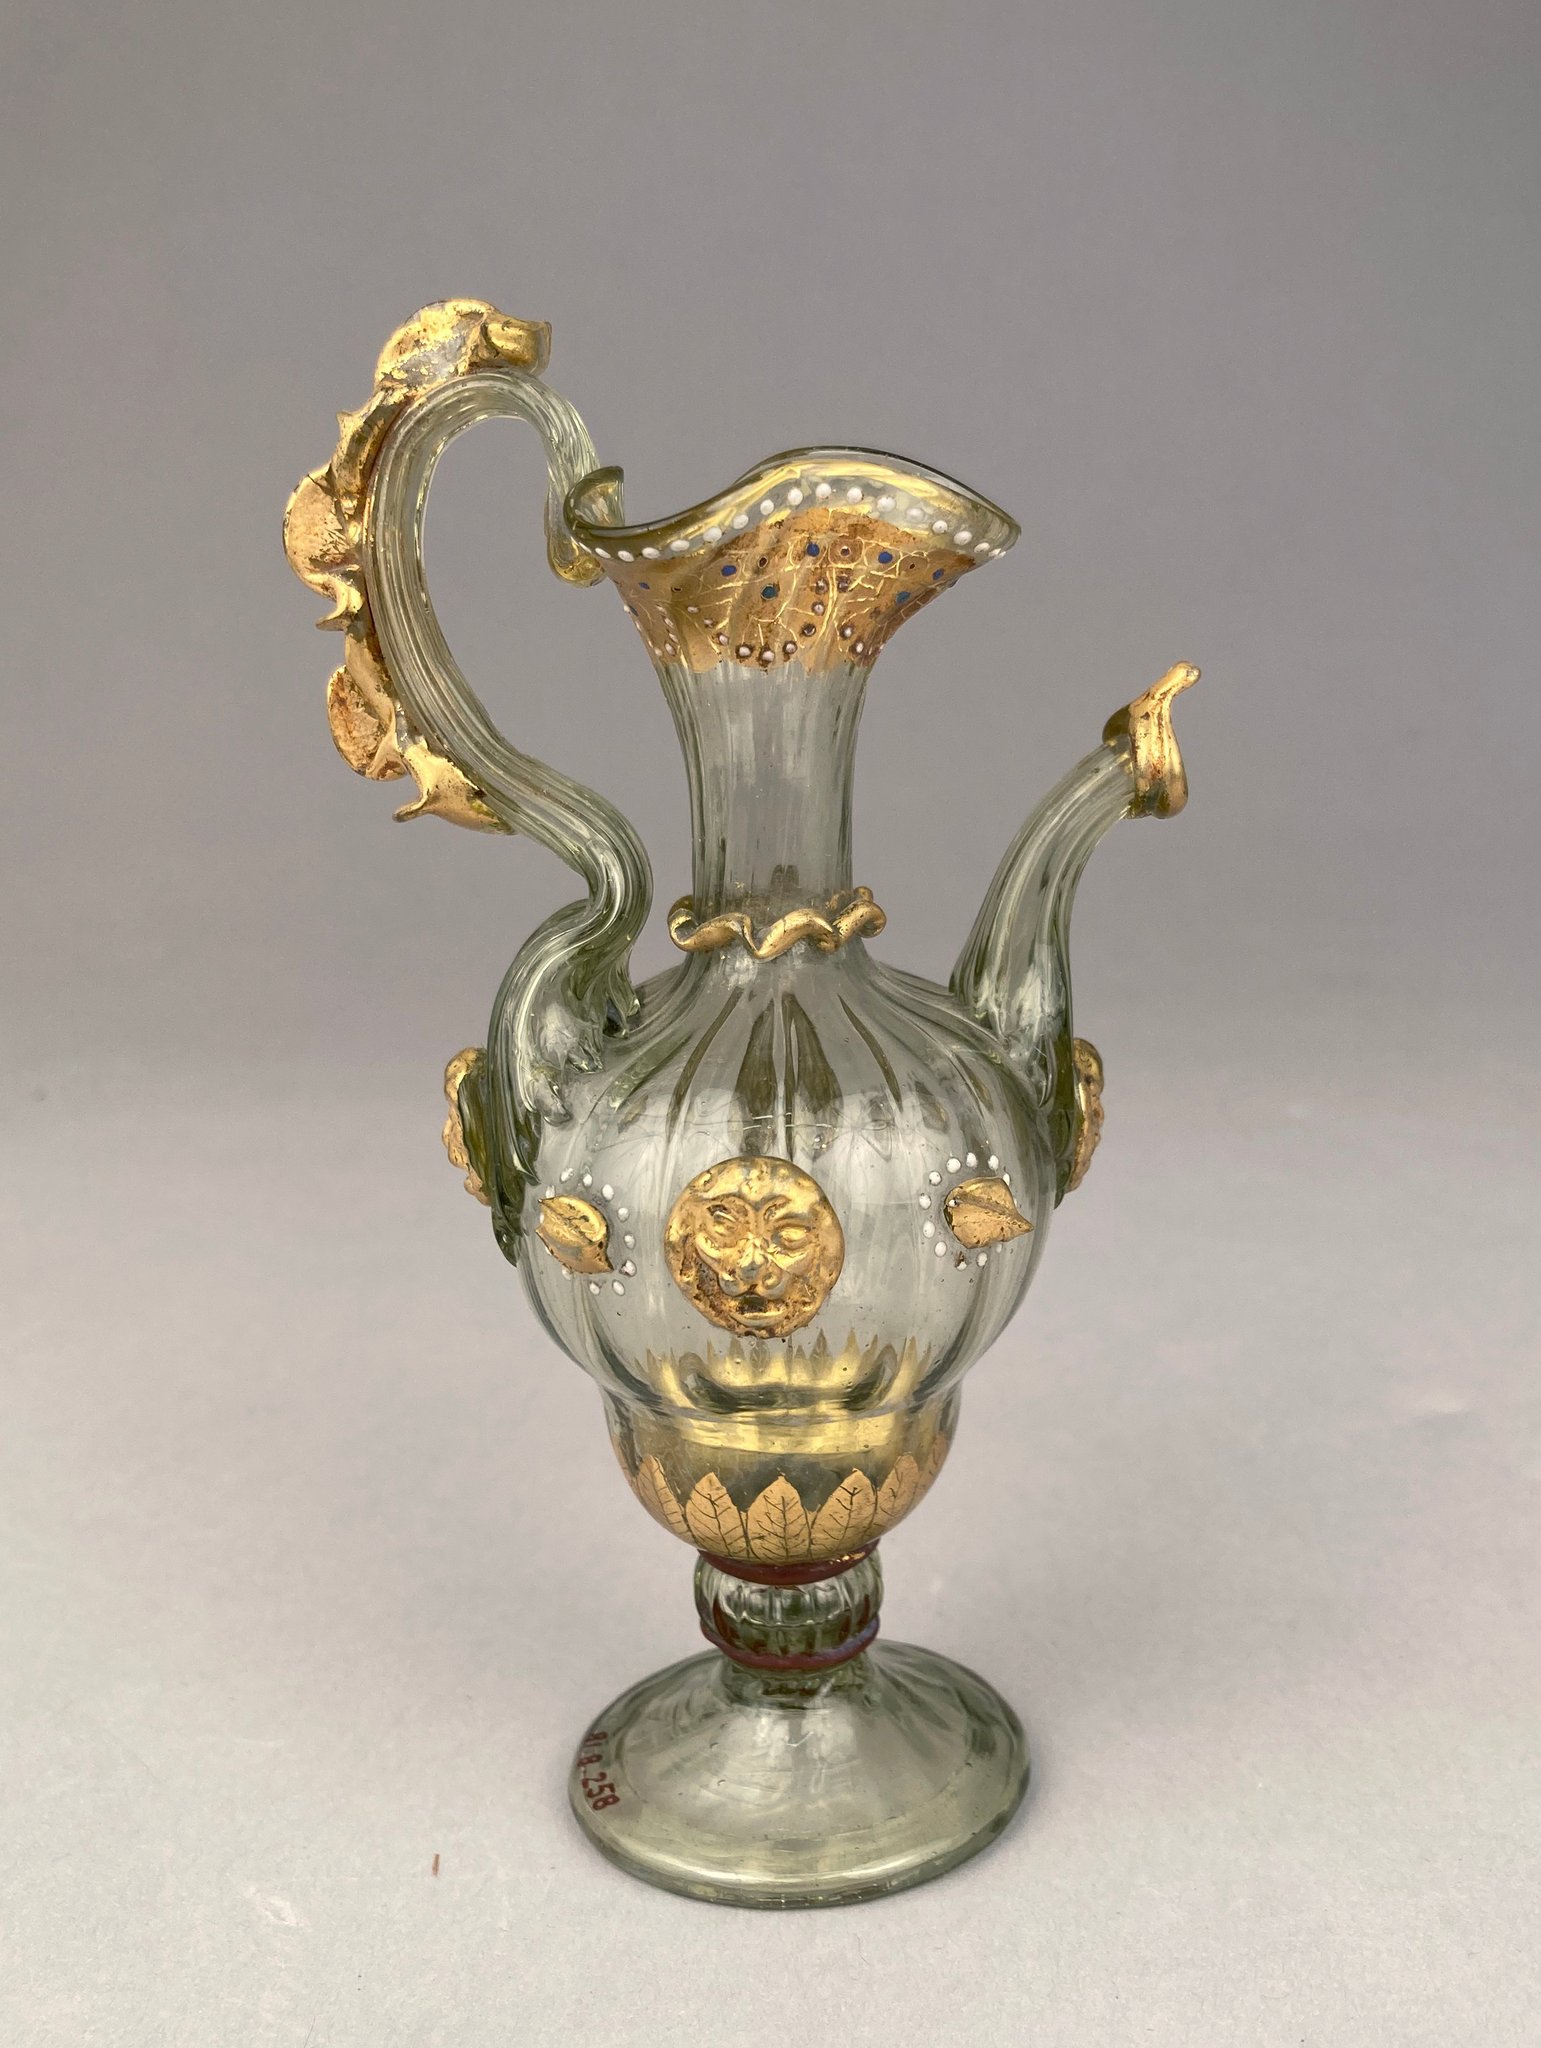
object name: ewer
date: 1801-1900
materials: glass